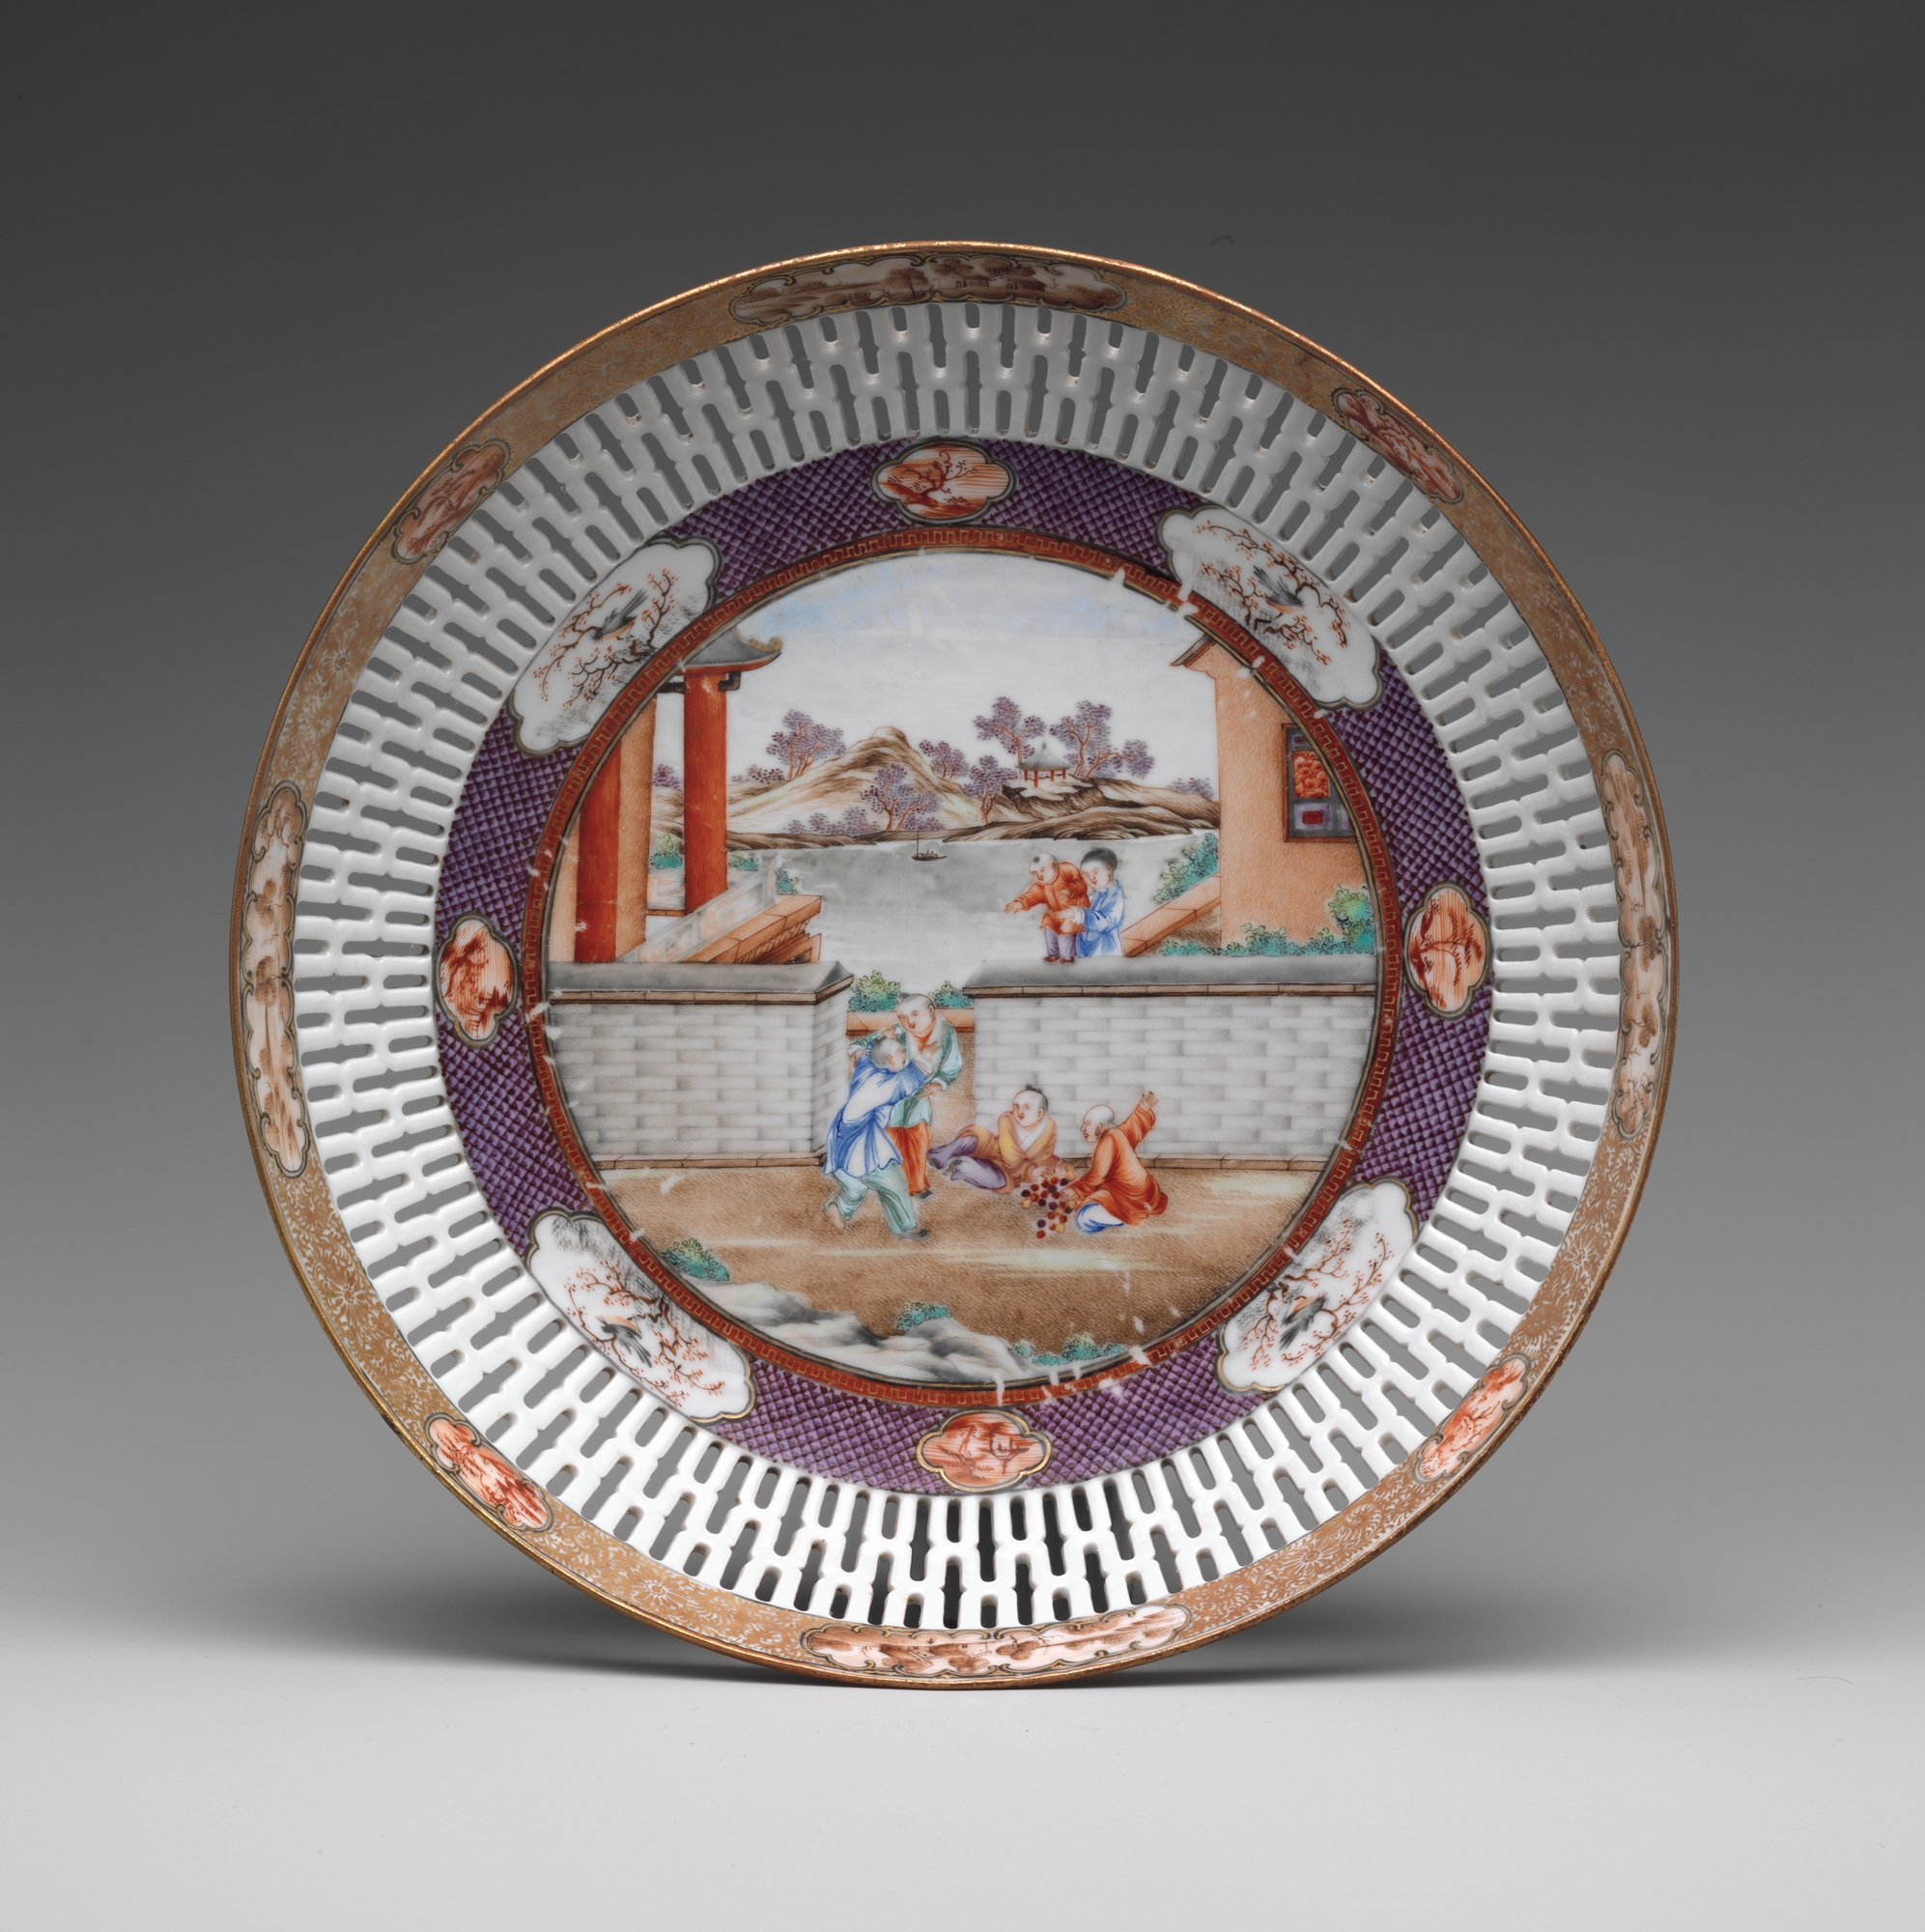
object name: dish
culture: chinese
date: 1736-1795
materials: porcelain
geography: china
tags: children,women,playing,landscapes